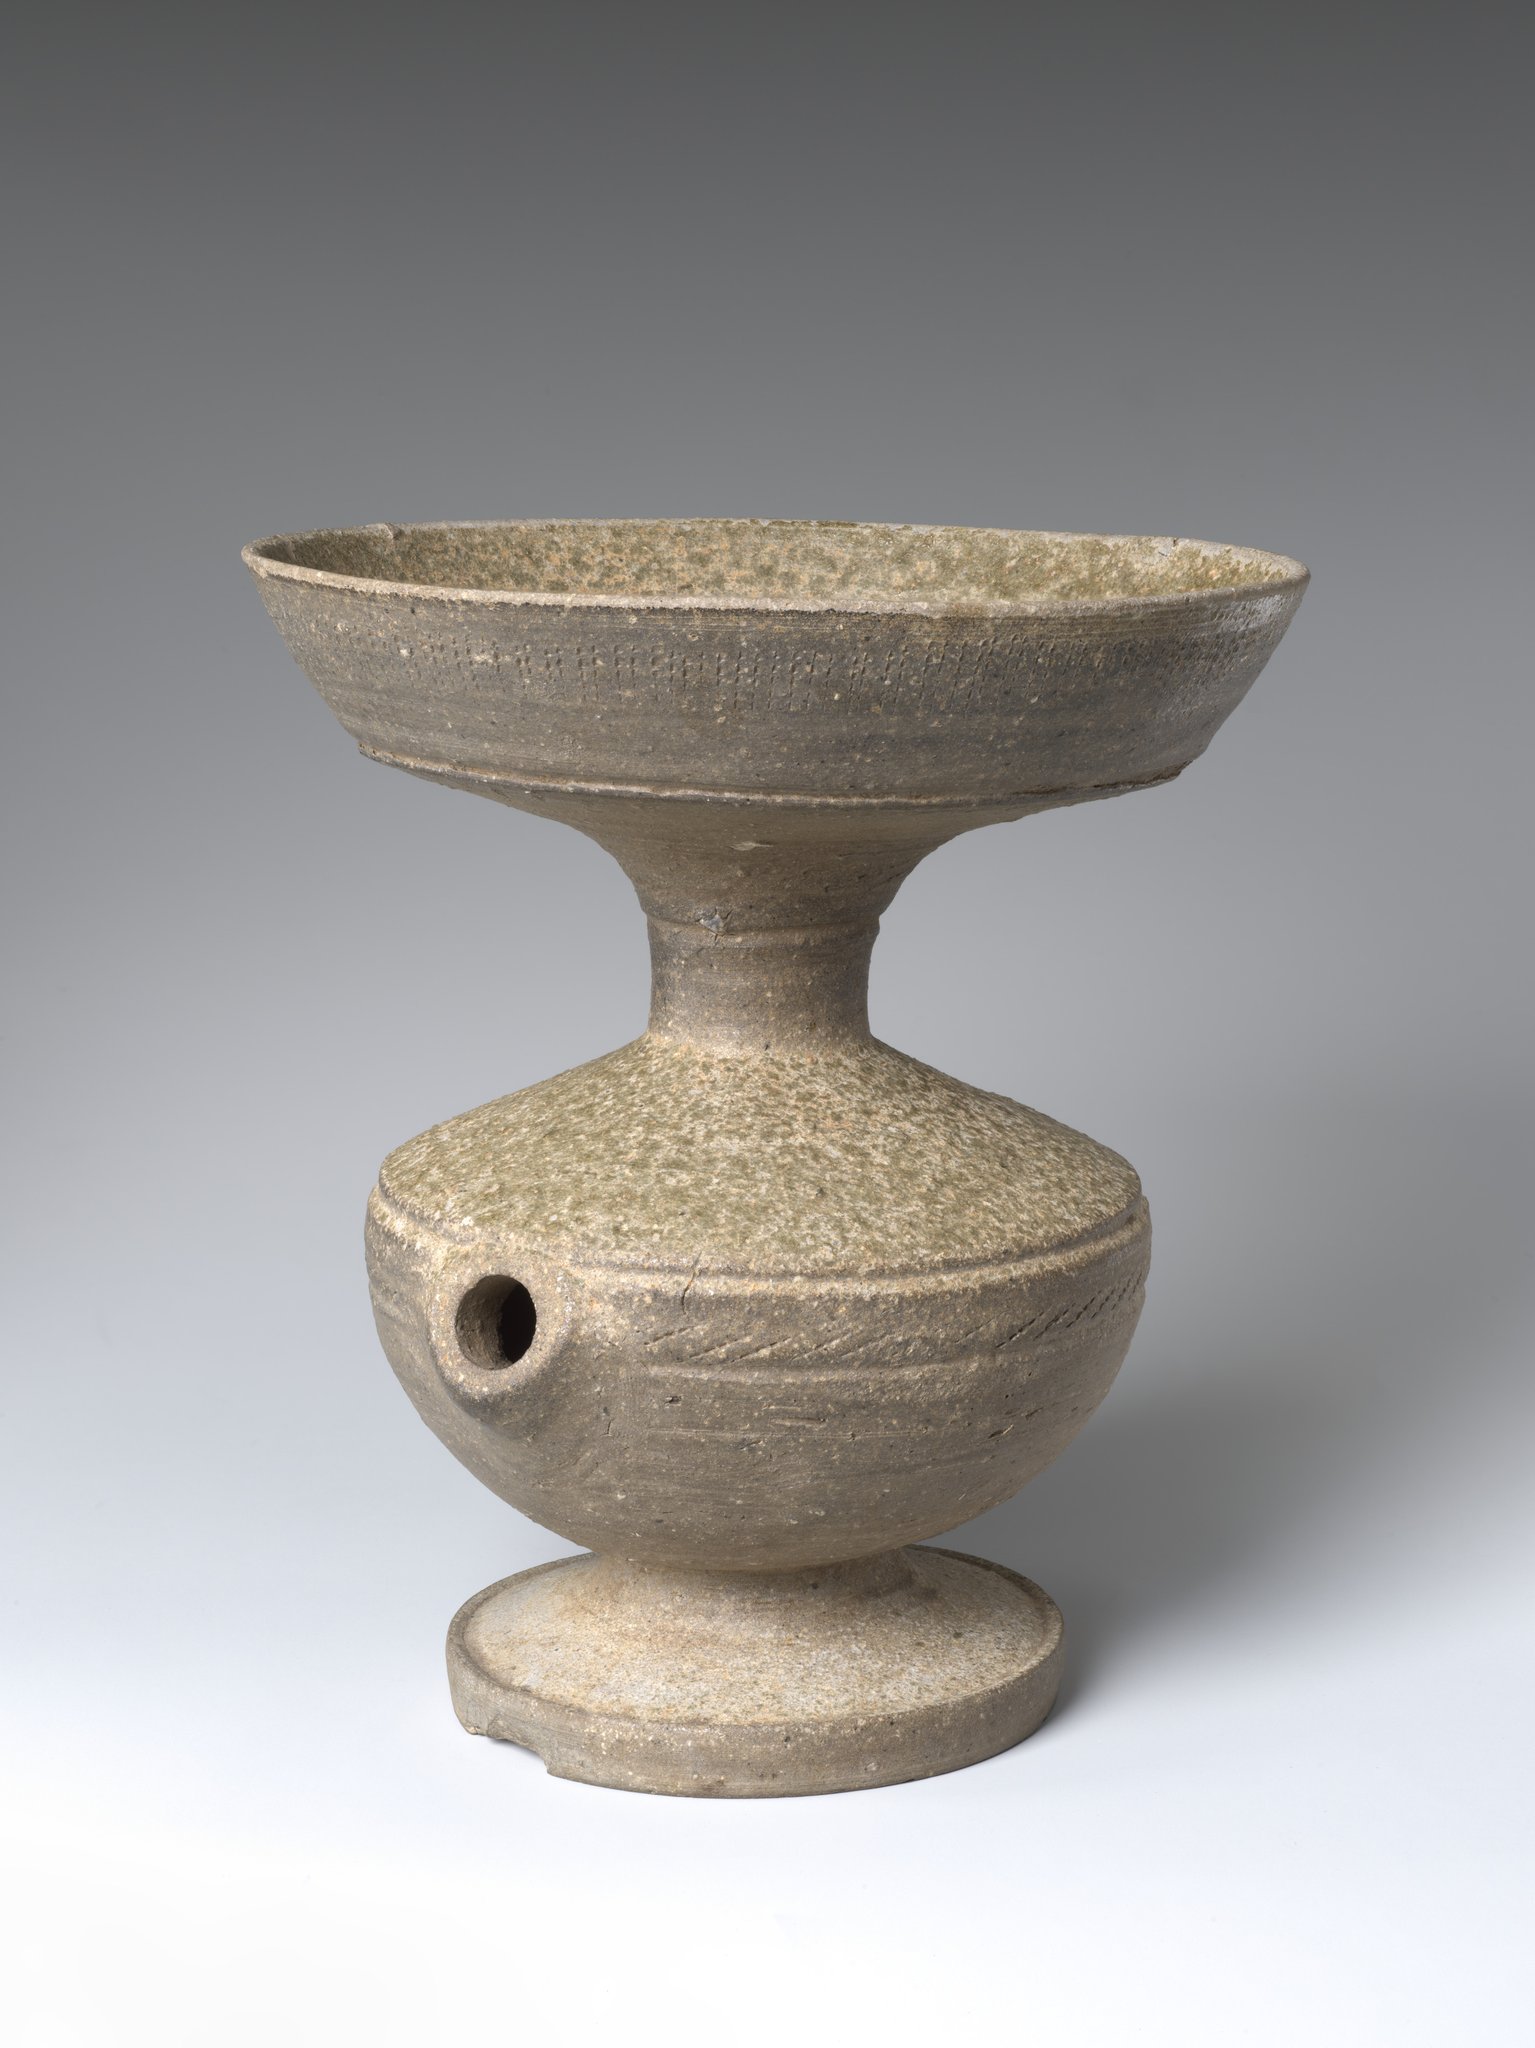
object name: jar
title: Vessel with Straw Hole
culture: japanese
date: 501-800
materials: wood, glaze, stoneware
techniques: incising